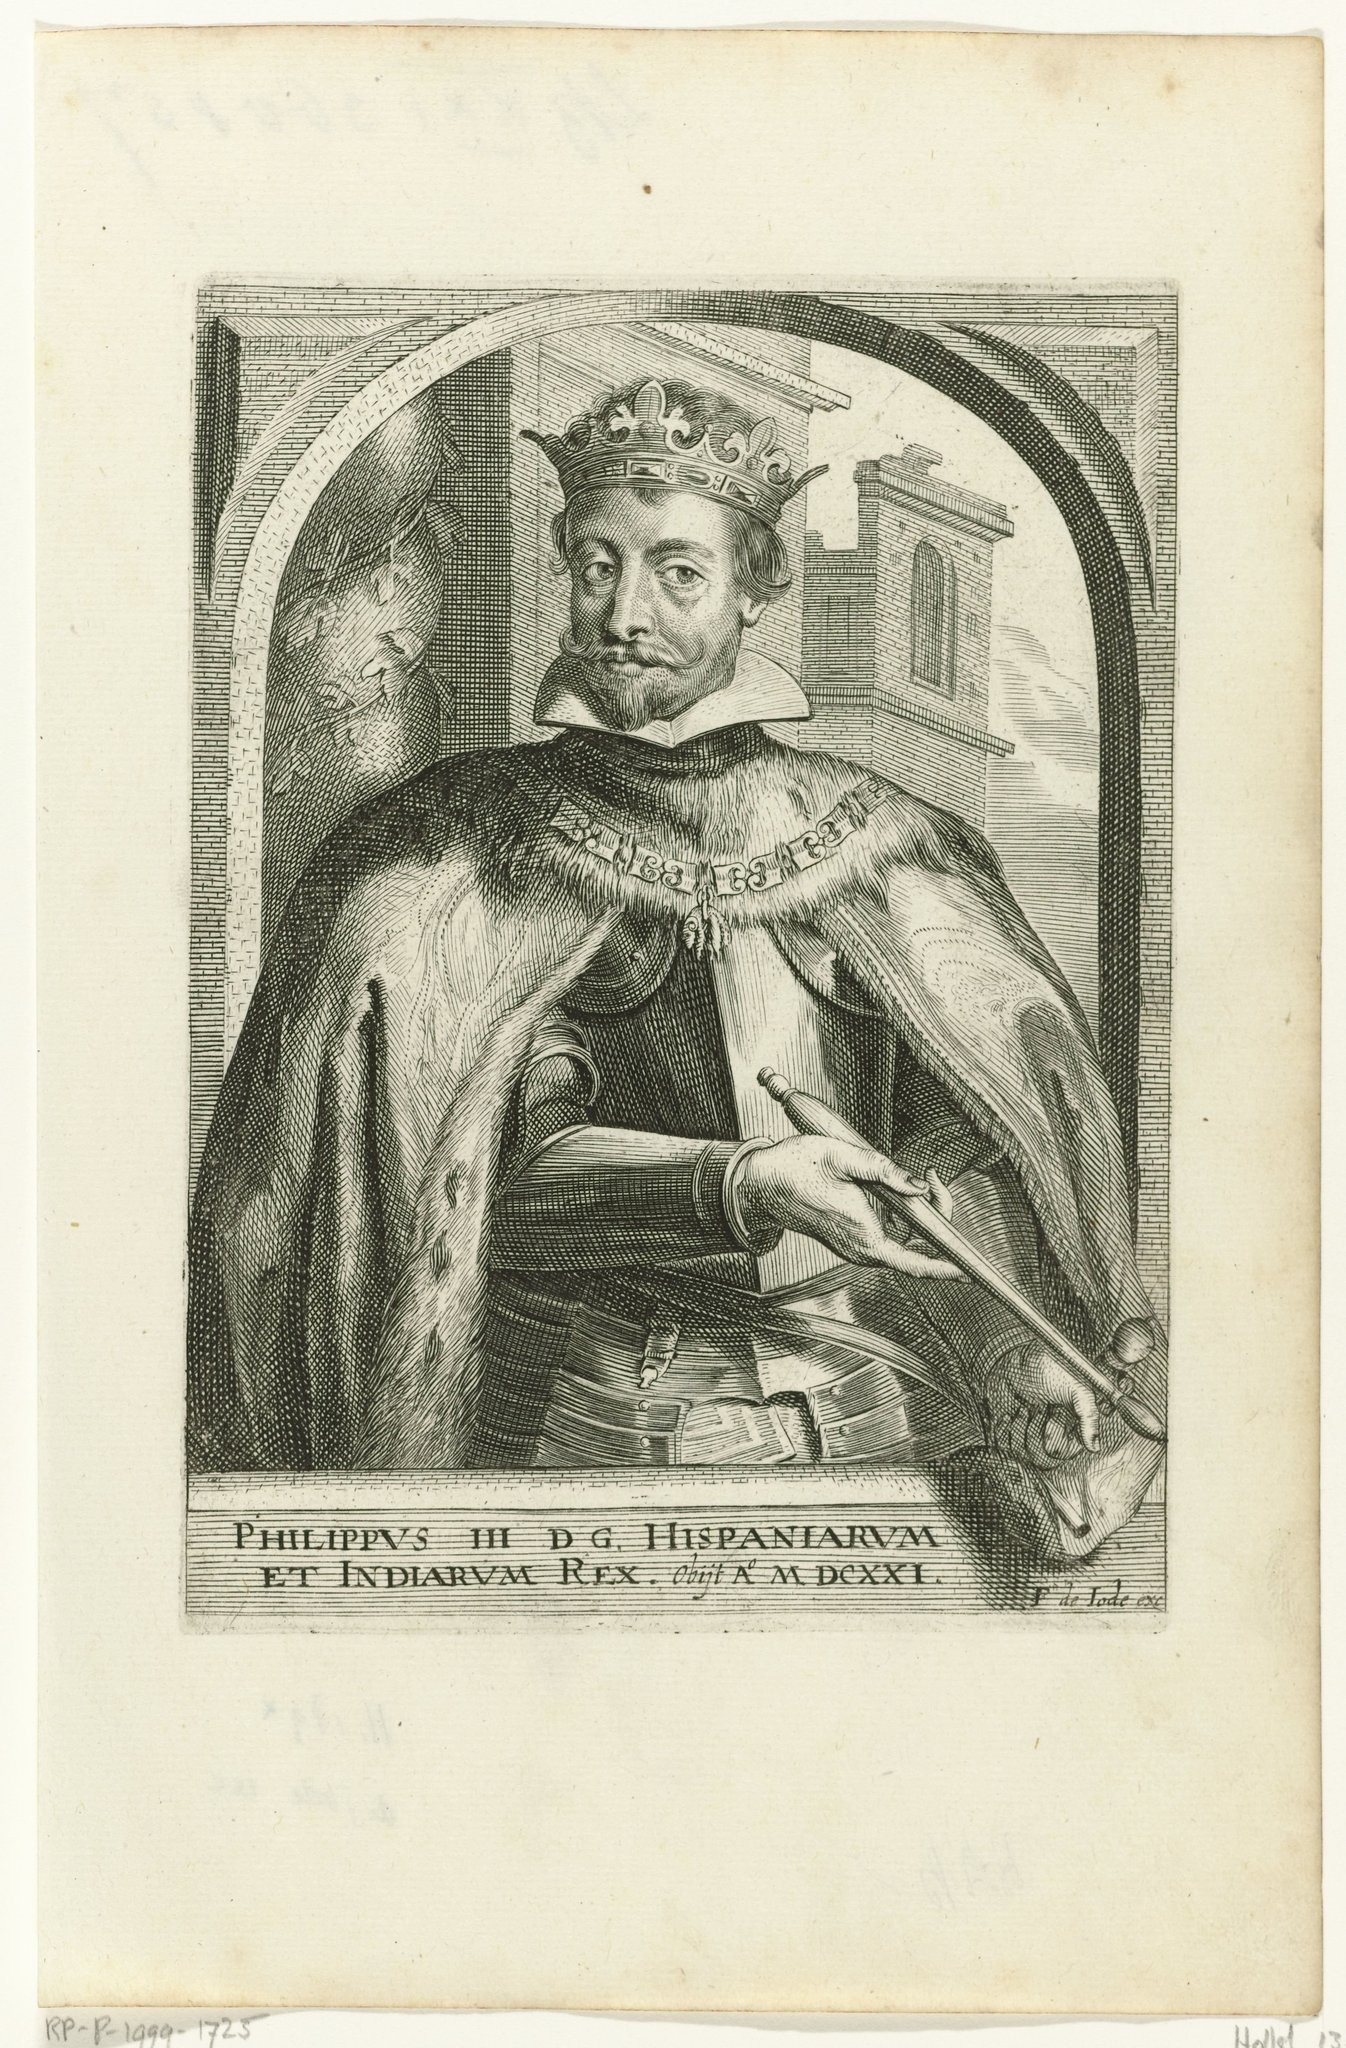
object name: print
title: Theater van bisschoppen, keizers, koningen, hertogen, prinsen, enz.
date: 1628-1670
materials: paper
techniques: engraving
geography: antwerp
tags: filips iii (koning van spanje), crown (symbol of sovereignty), sceptre, staff (symbol of sovereignty), armour, knighthood order of the golden fleece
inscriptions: collector's mark: Lugt 2760, collector's mark: Lugt 2228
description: Portret van Filips III, ten halven lijve. Hij is gekroond en draagt een harnas, een mantel en een keten met de Orde van het Gulden Vlies. In zijn rechterhand houdt hij een scepter. Het portret is gevat in een boogvormige omlijsting met vierkant randwerk. In de marge een tweeregelig onderschrift in het Latijn.